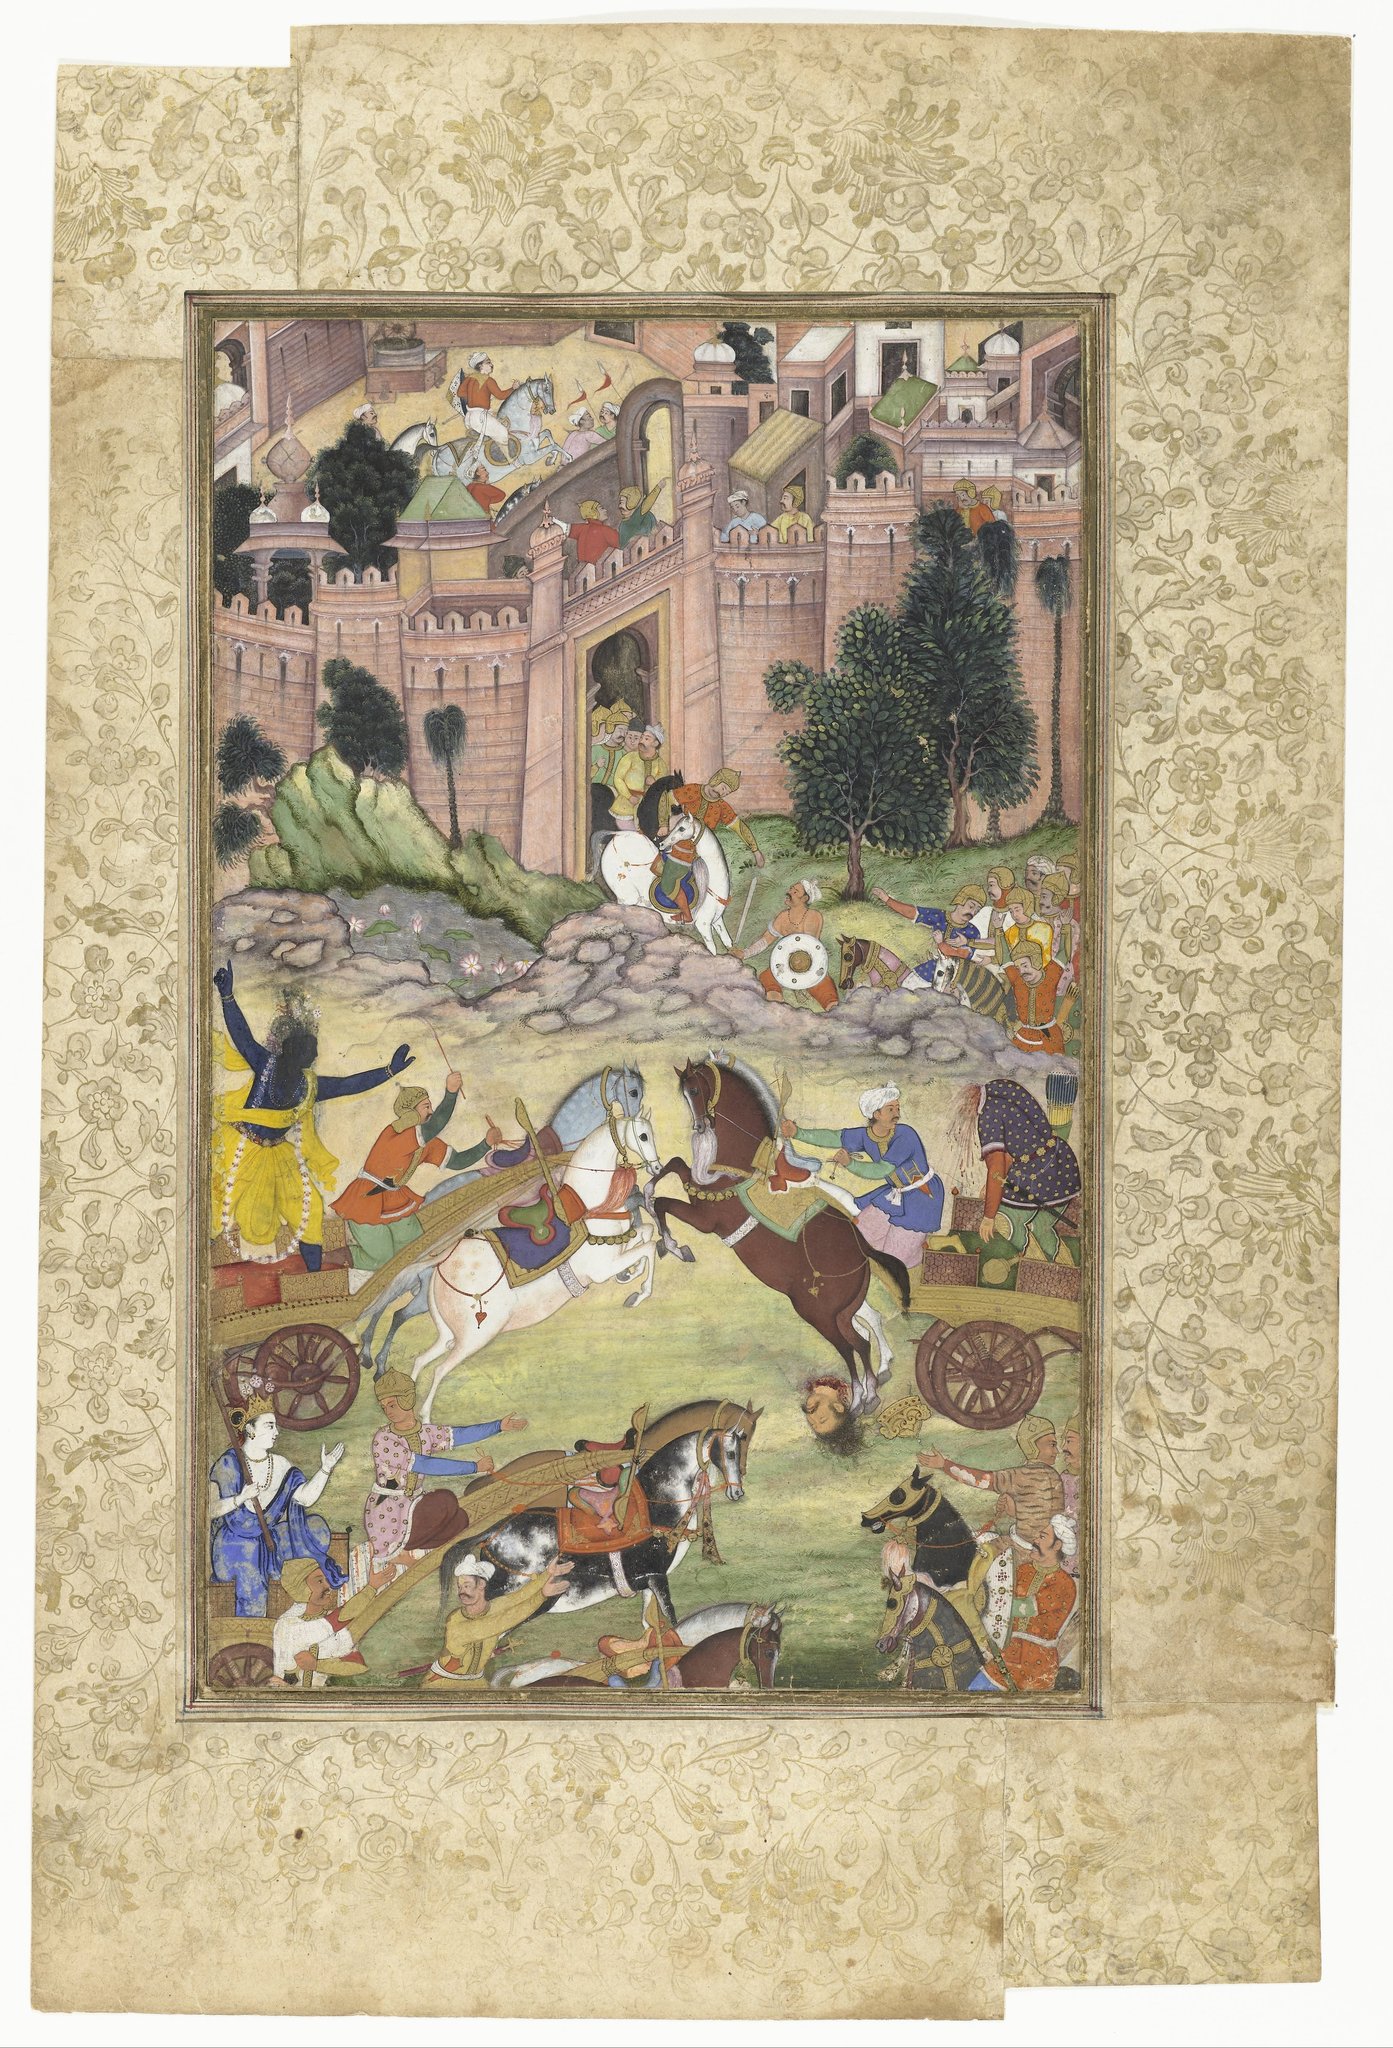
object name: indian miniature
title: Krishna doodt de demon Sri Gala (scene uit de Harivamsa)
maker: Anonymous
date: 1585-1595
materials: paint, gouache, paper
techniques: brush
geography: india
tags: demons ~ non-christian religions, krishna, 8th incarnation of vishnu